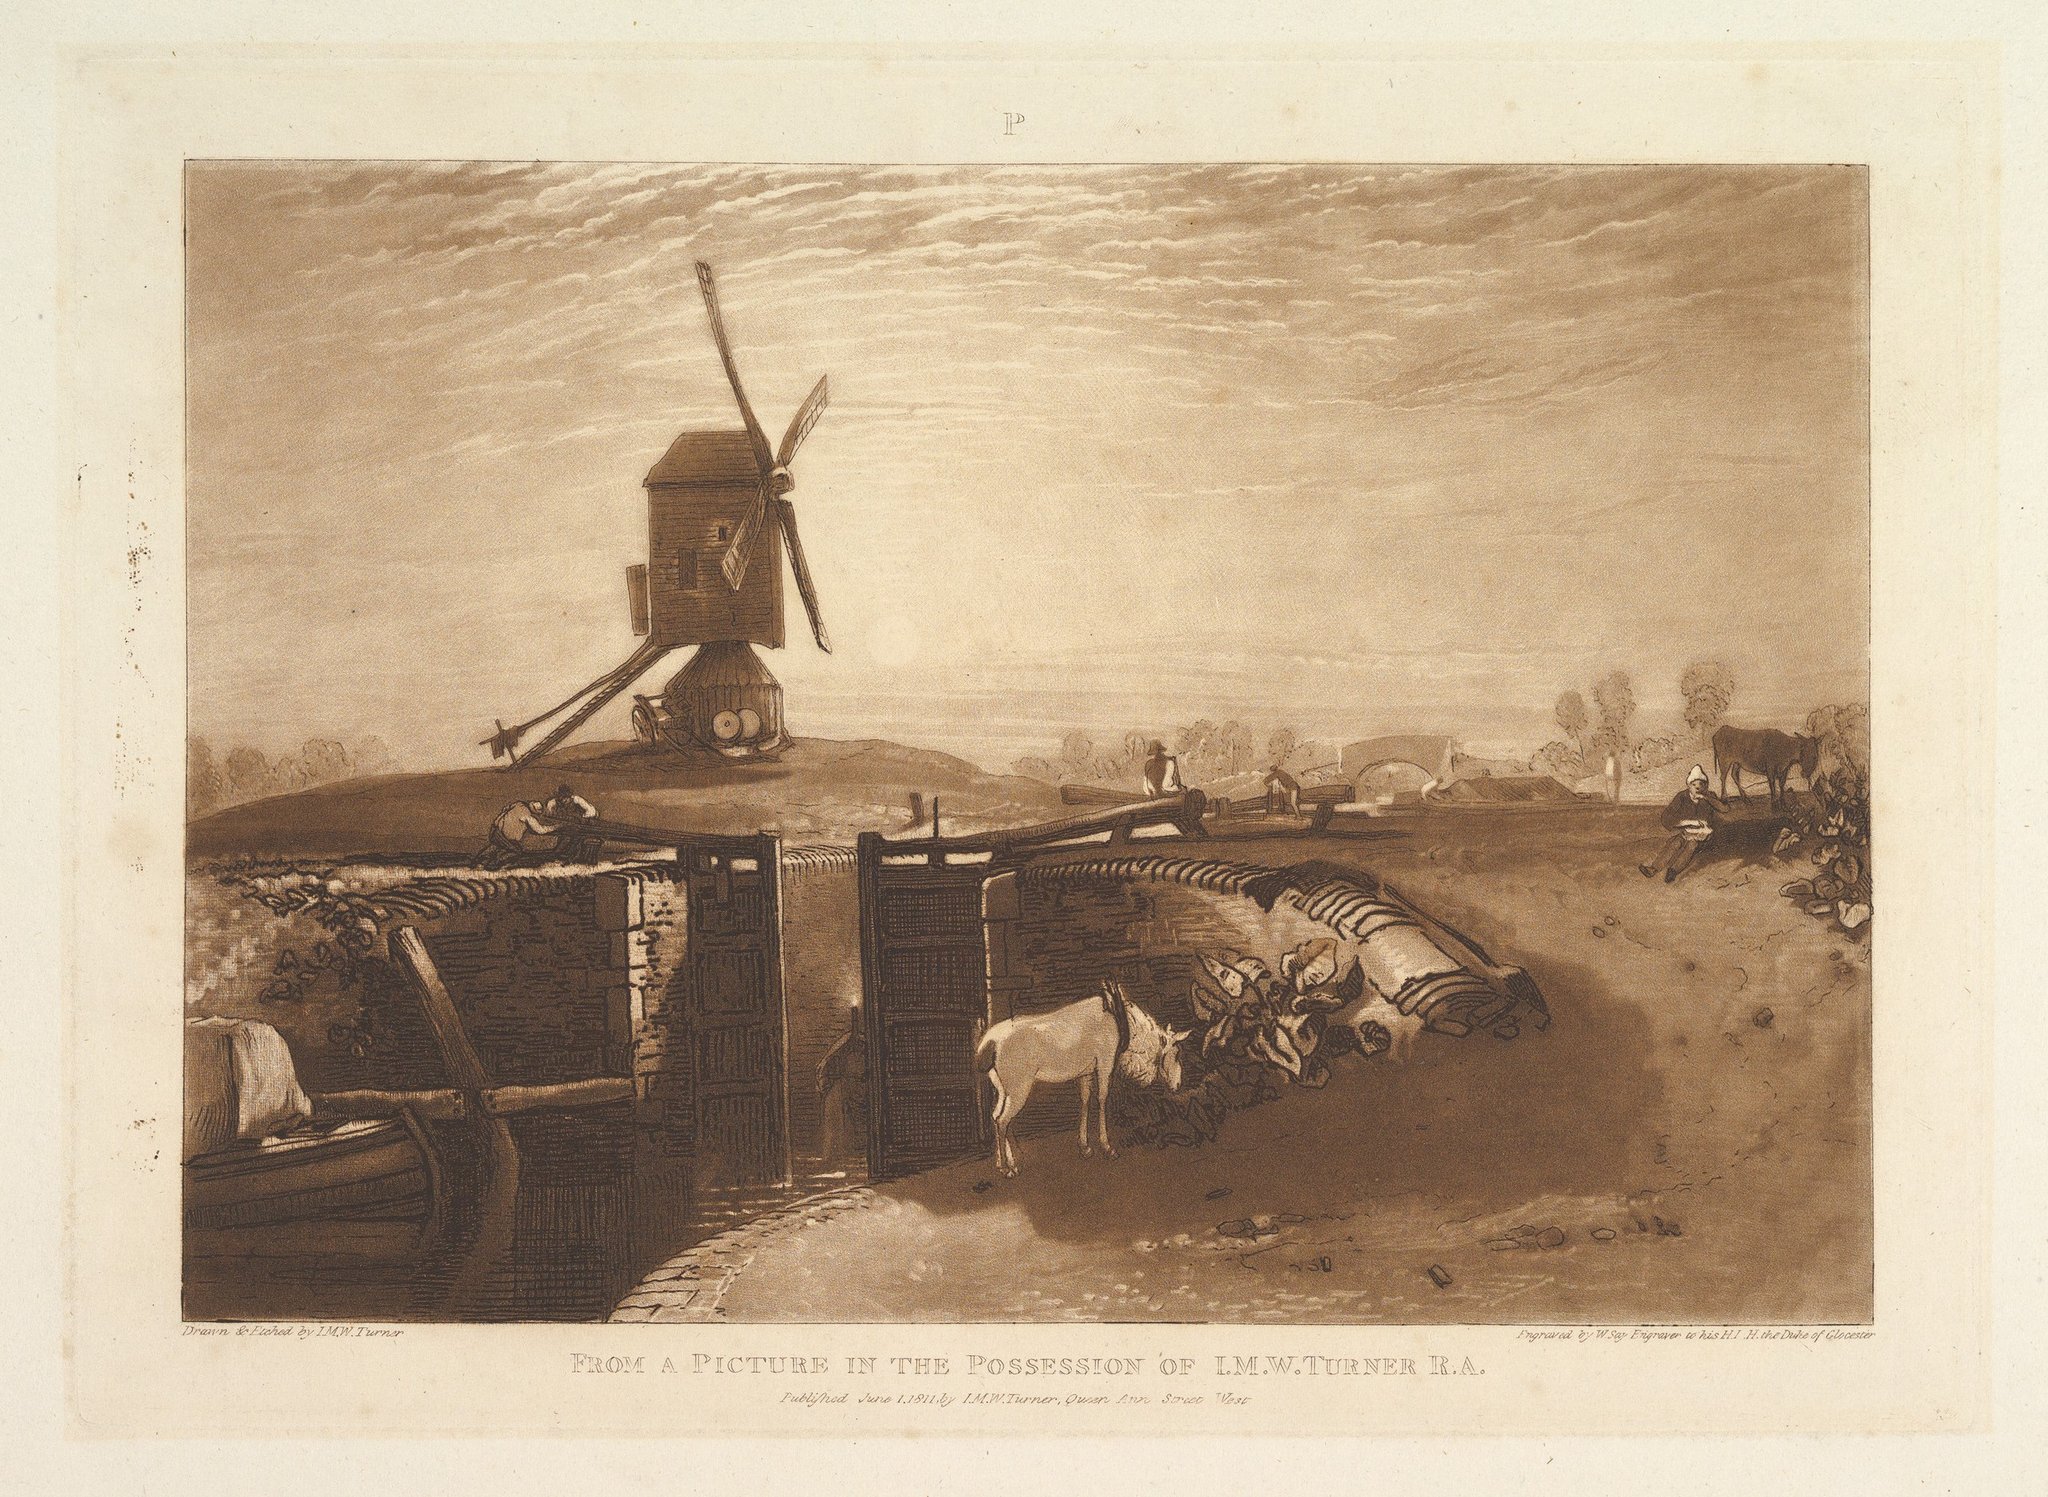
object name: print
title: Windmill and Lock, part VI, plate 27 from "Liber Studiorum"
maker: joseph mallord william turner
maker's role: artist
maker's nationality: british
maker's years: 1775-1851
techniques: etching, mezzotint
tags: windmills,men,cows,evening